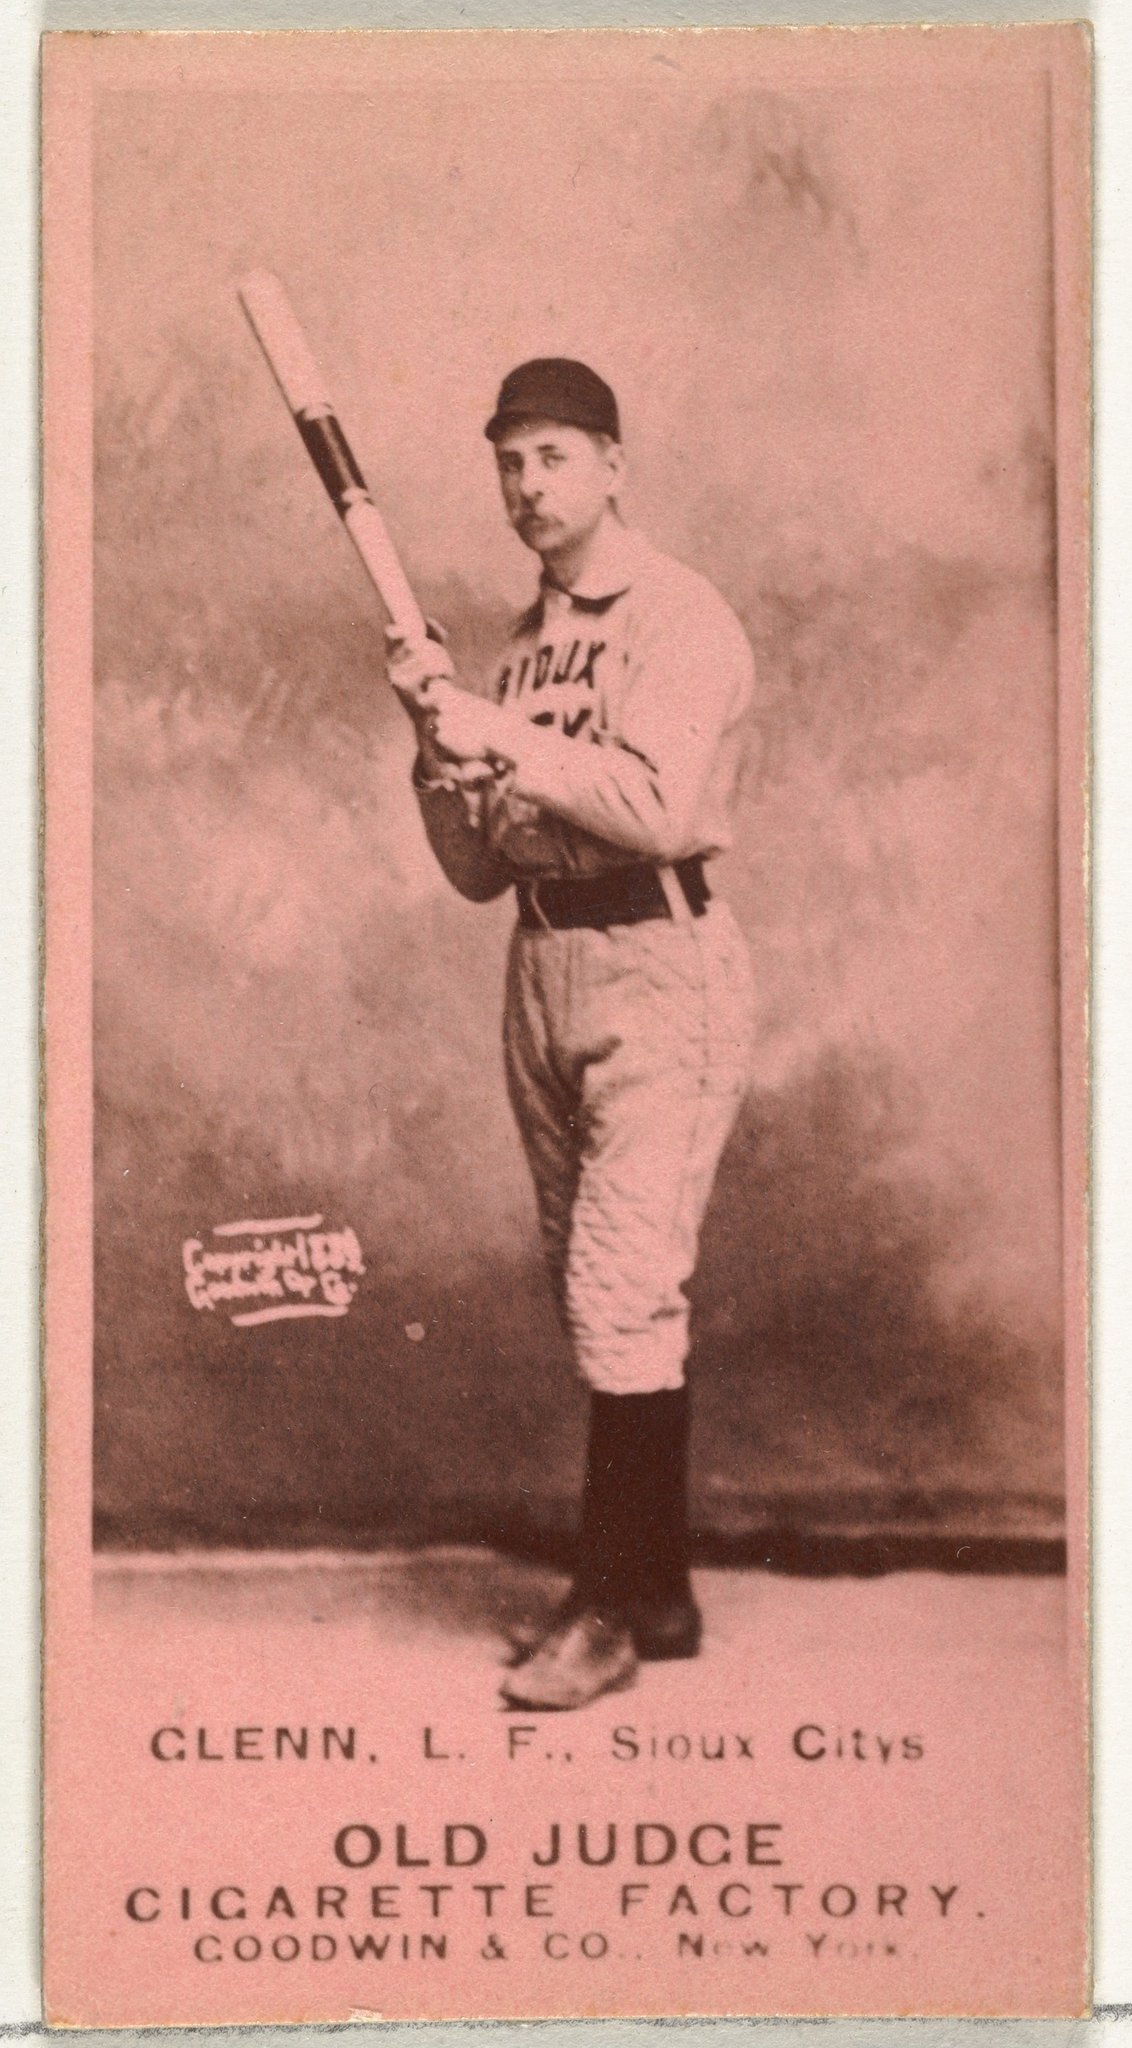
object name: baseball card, photograph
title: Edward C. "Mouse" Glenn, Left Field, Sioux City Corn Huskers, from the Old Judge series (N172) for Old Judge Cigarettes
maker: goodwin & company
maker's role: publisher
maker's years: 1850-1950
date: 1889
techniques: albumen silver print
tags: men,portraits,baseball,athletes